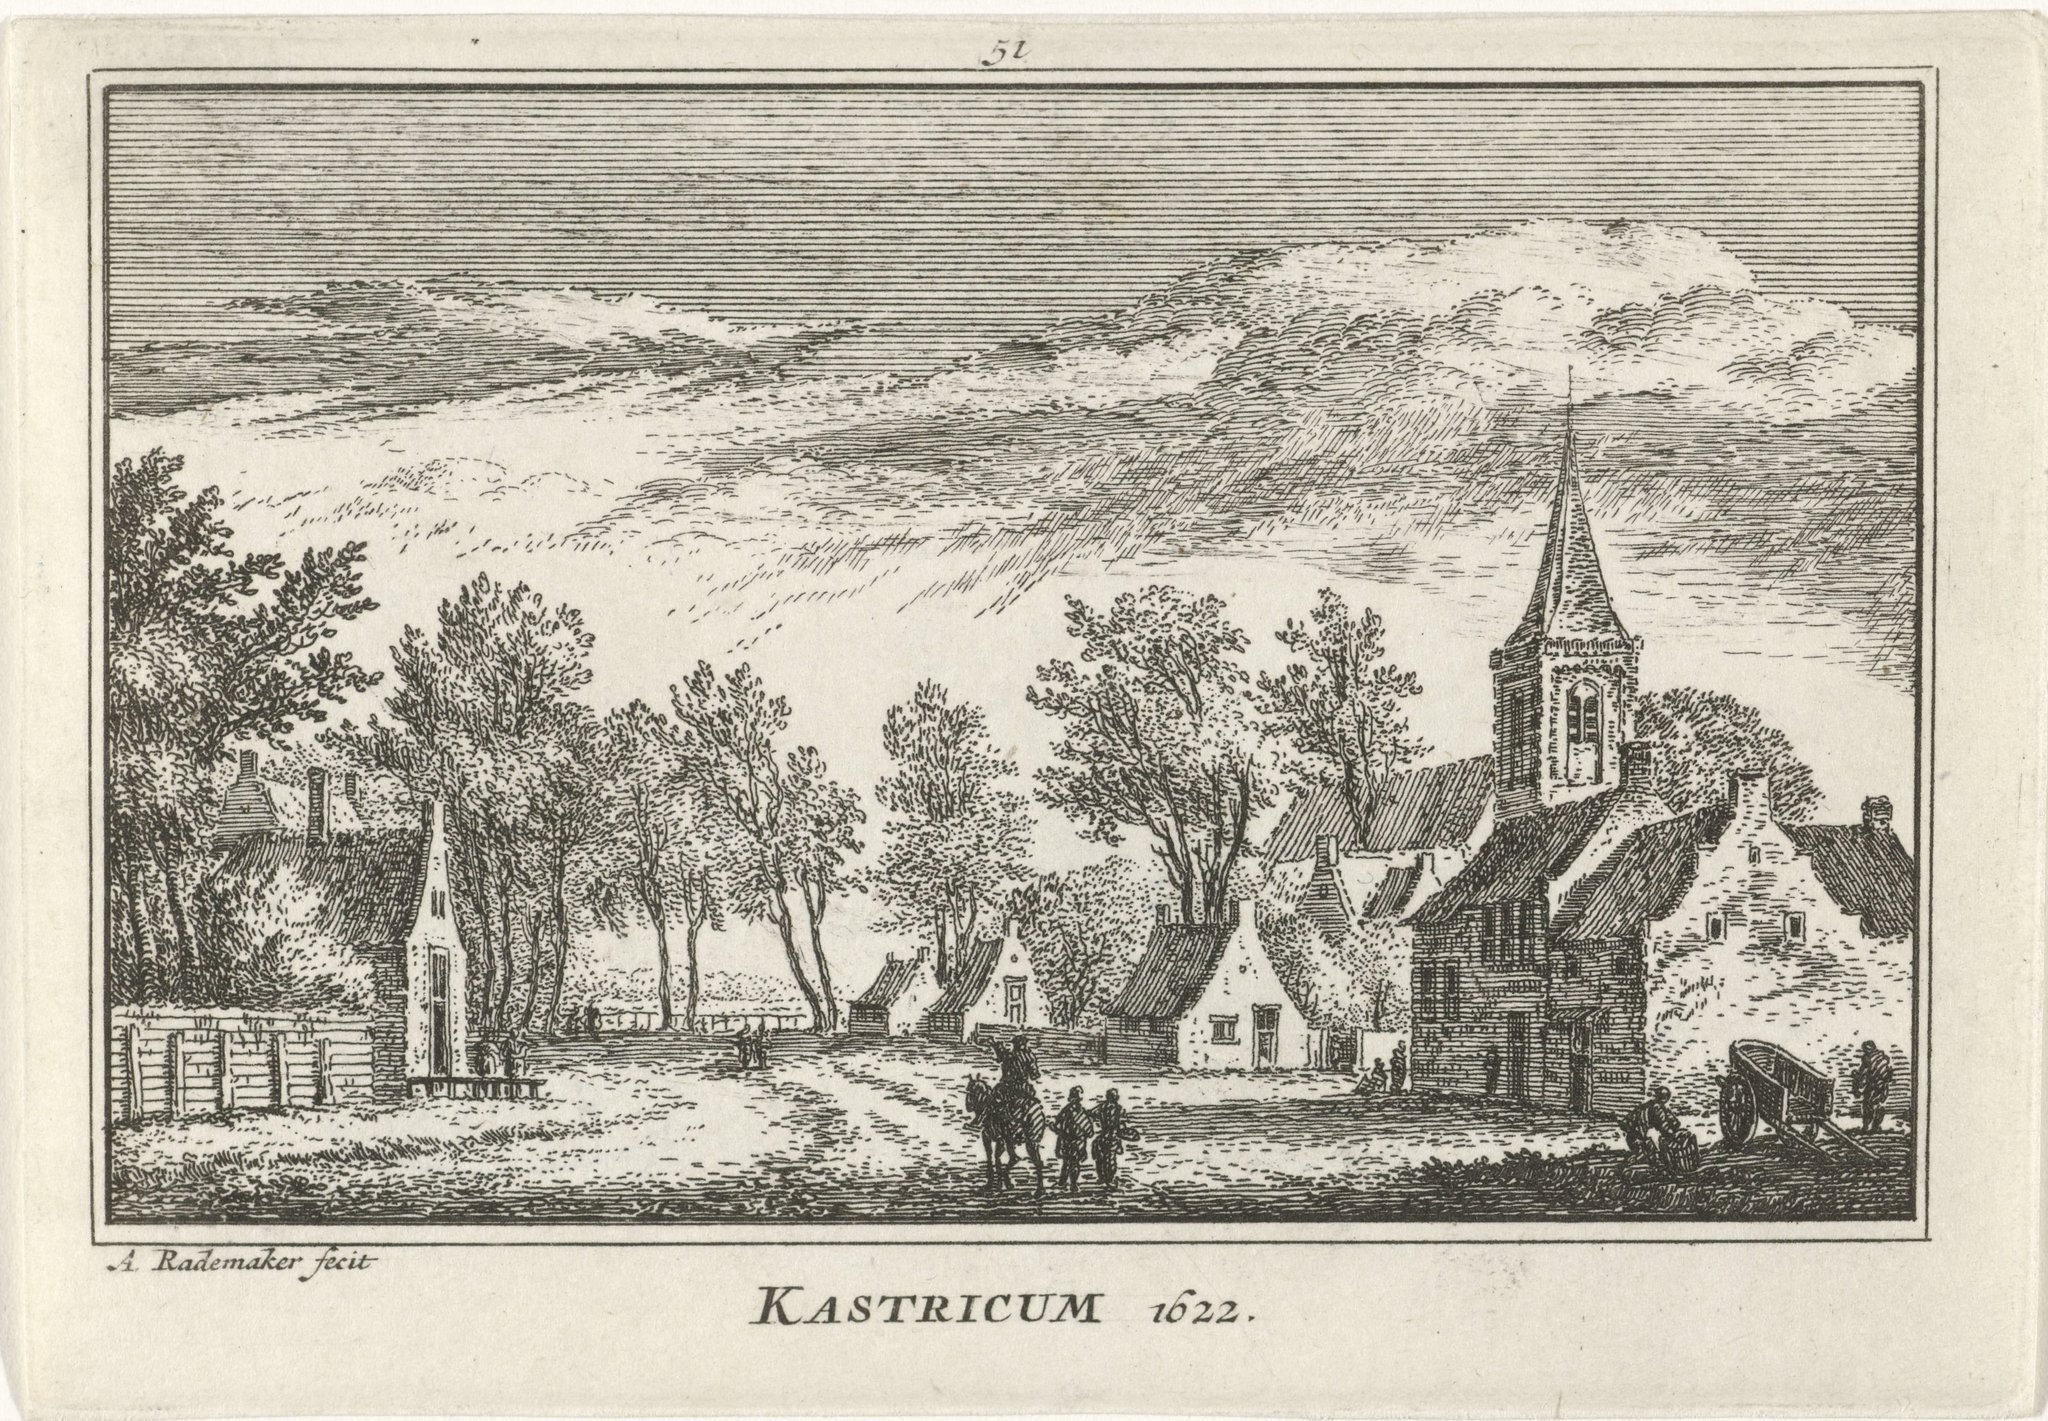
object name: book illustration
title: Kastricum 1622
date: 1727-1733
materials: paper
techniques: etching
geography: amsterdam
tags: prospect of village, silhouette of village, church (exterior)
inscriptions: collector's mark: Lugt 2228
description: Illustratie uit: Abraham Rademaker, Matthaeus Brouërius van Niedek, Isaac Le Long, Kabinet van Nederlandsche en Kleefsche outheden en (...) voorname stads- en landgebouwen, Willem Barents en Antoni Schoonenburg: Amsterdam, 1727-1733, ill. nr. 45.